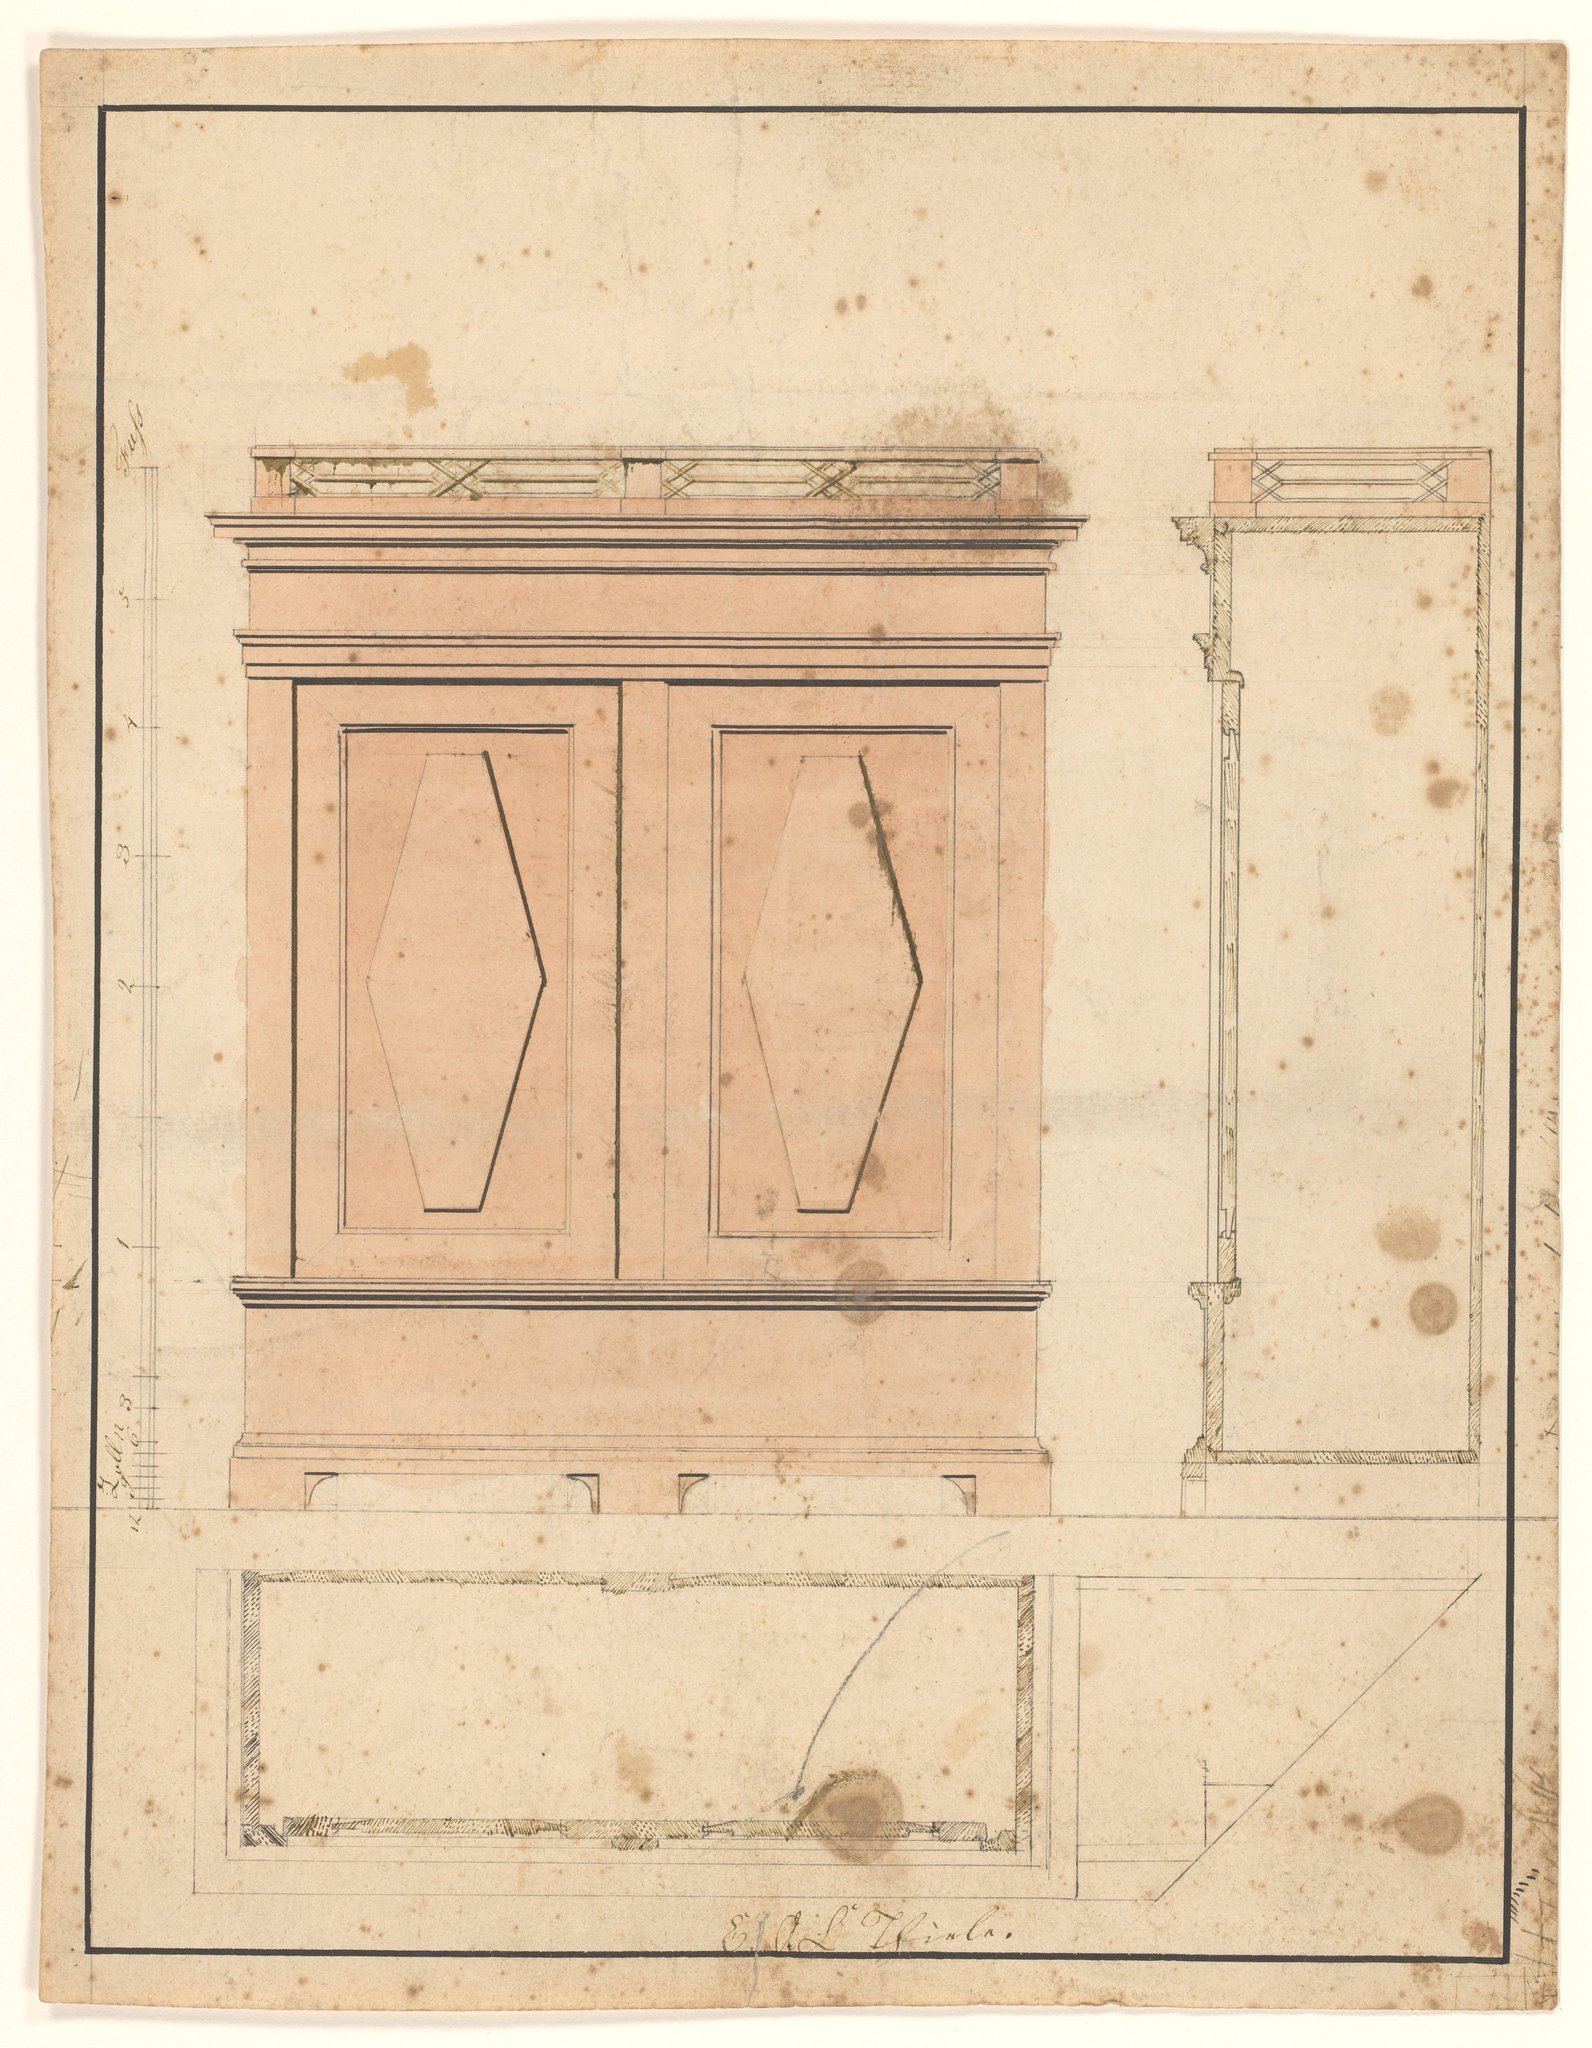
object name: design drawing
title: Ontwerp voor een tweedeurskast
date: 1800-1810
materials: ink, paper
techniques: brush, pen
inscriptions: signature: ‘E.R.L. [?] Thiele’, watermark: ‘VDL’, inscription: ‘Zolln 12 9 6 3 1 2 3 4 5 Fuss’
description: Voor- en zijaanzicht, met daaronder een plattegrond, links een maatverdeling.